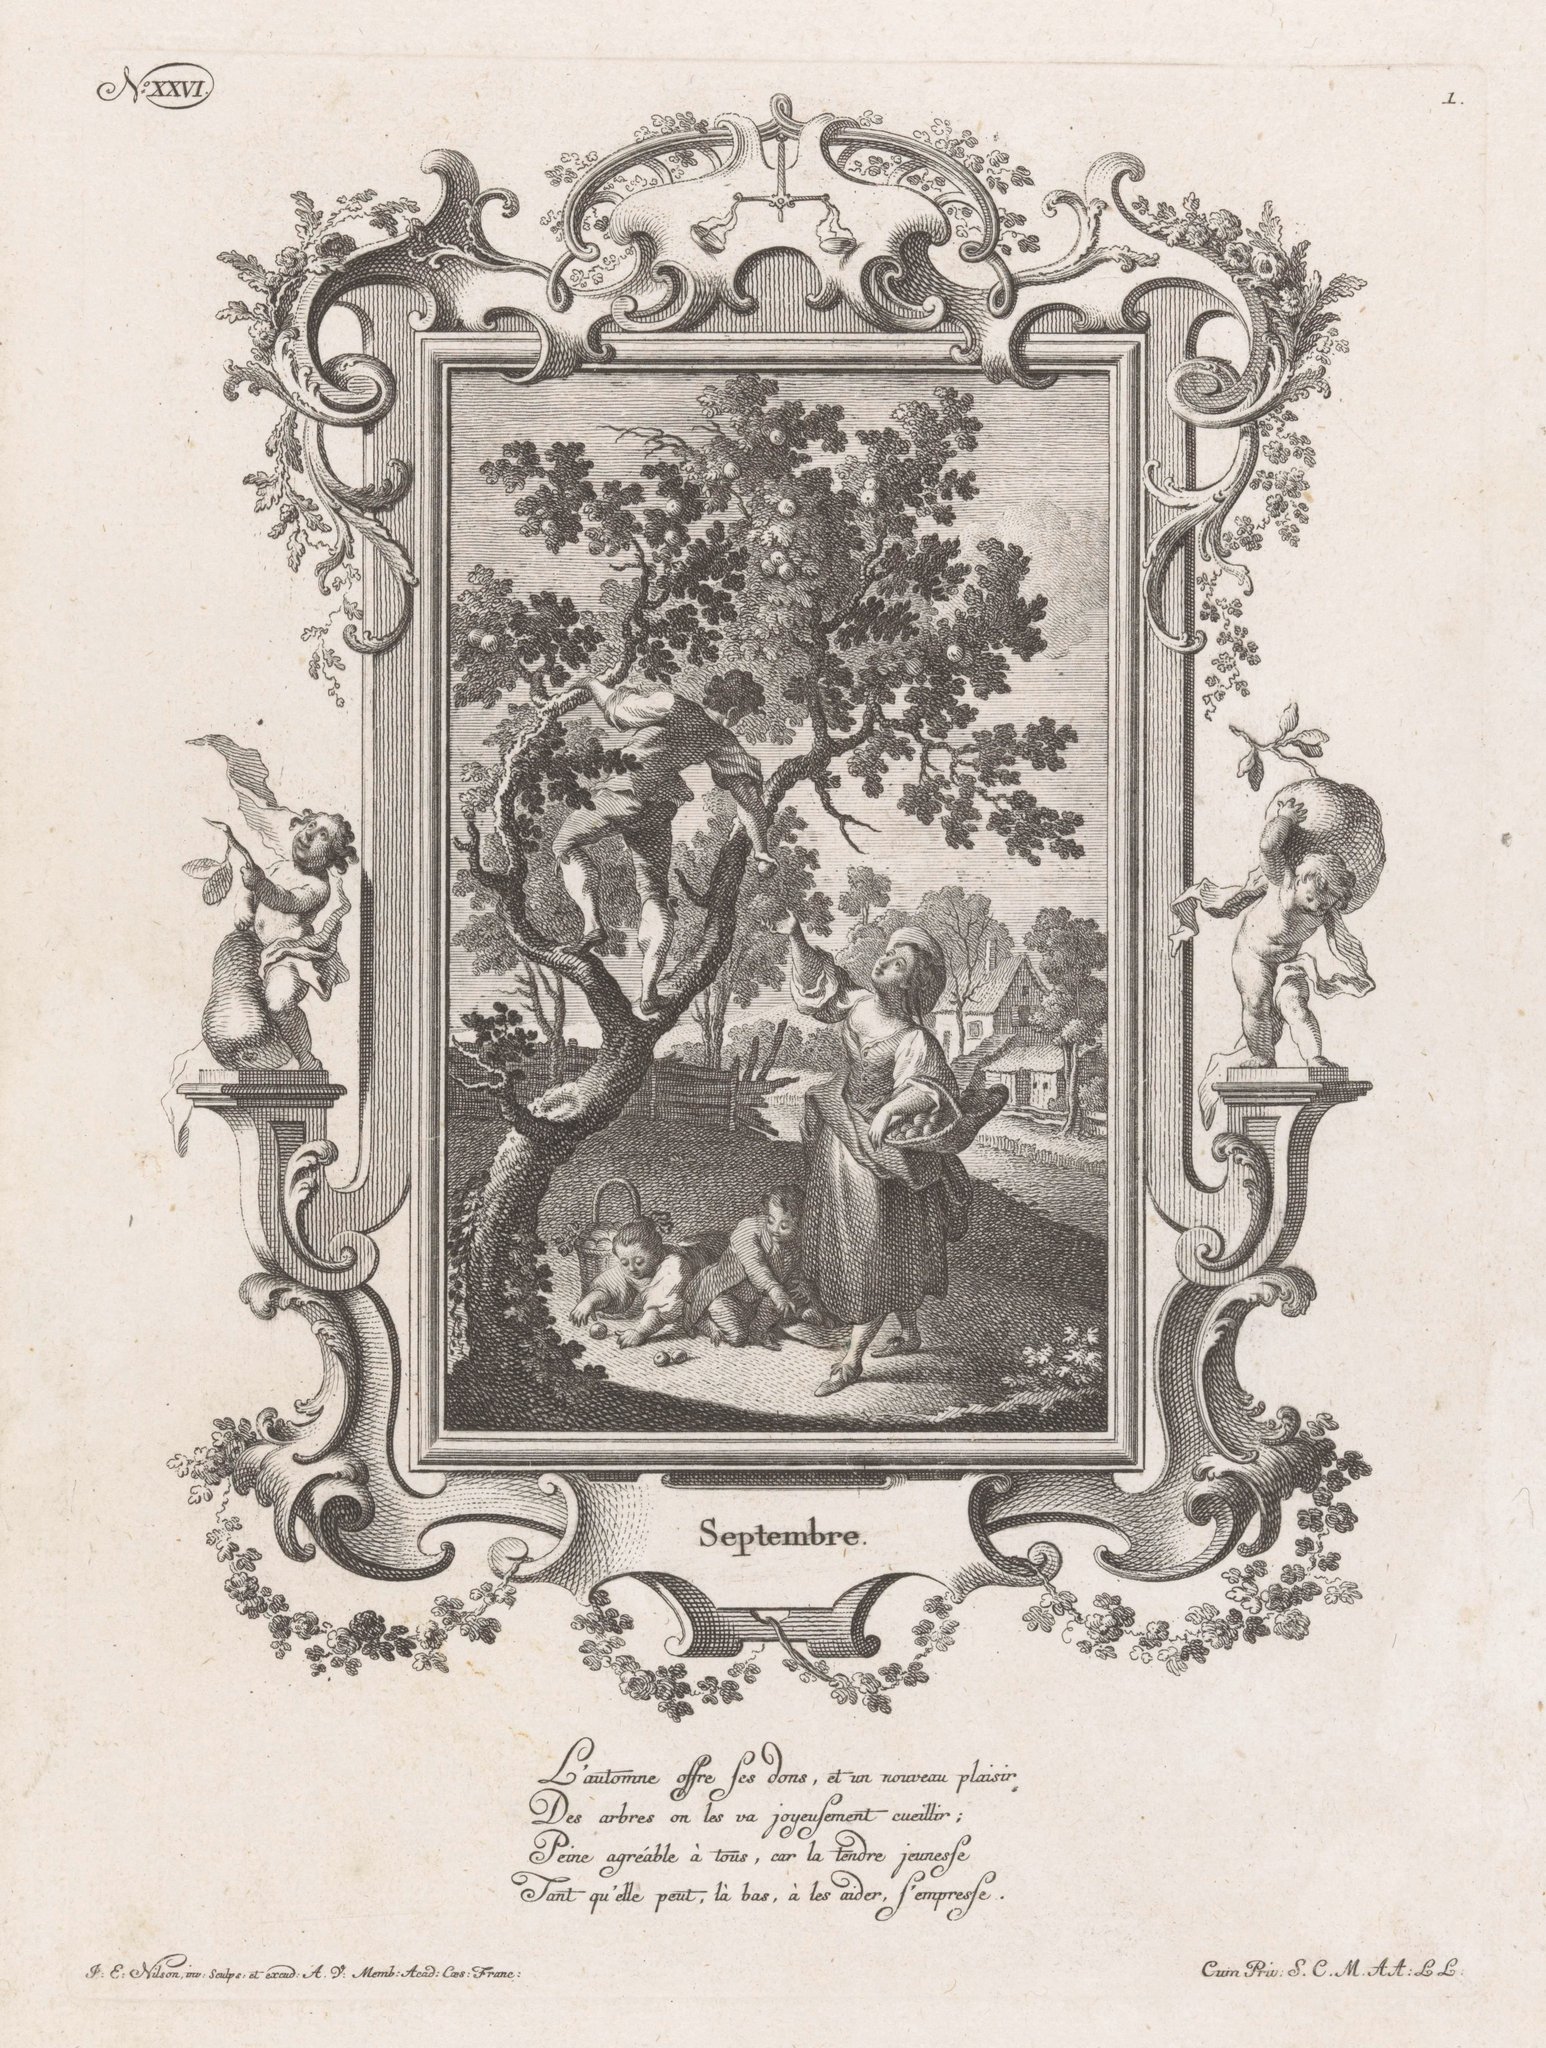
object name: ornament print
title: Septembre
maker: johann esaias nilson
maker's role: draughtsman, print maker, publisher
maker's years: 1721-1788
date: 1766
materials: paper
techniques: engraving, etching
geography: augsburg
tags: september and its 'labours', picking fruit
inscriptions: collector's mark: Lugt 2228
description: In een rocaille omlijsting met putti met vruchten een voorstelling van fruitplukkers. Een man in een boom plukt fruit en geeft het aan een vrouw met een mand. Onder de boom verzamelen twee kinderen het gevallen fruit. In de ondermarge een vierregelige Franse tekst. Uitgeversnummer XXVI.